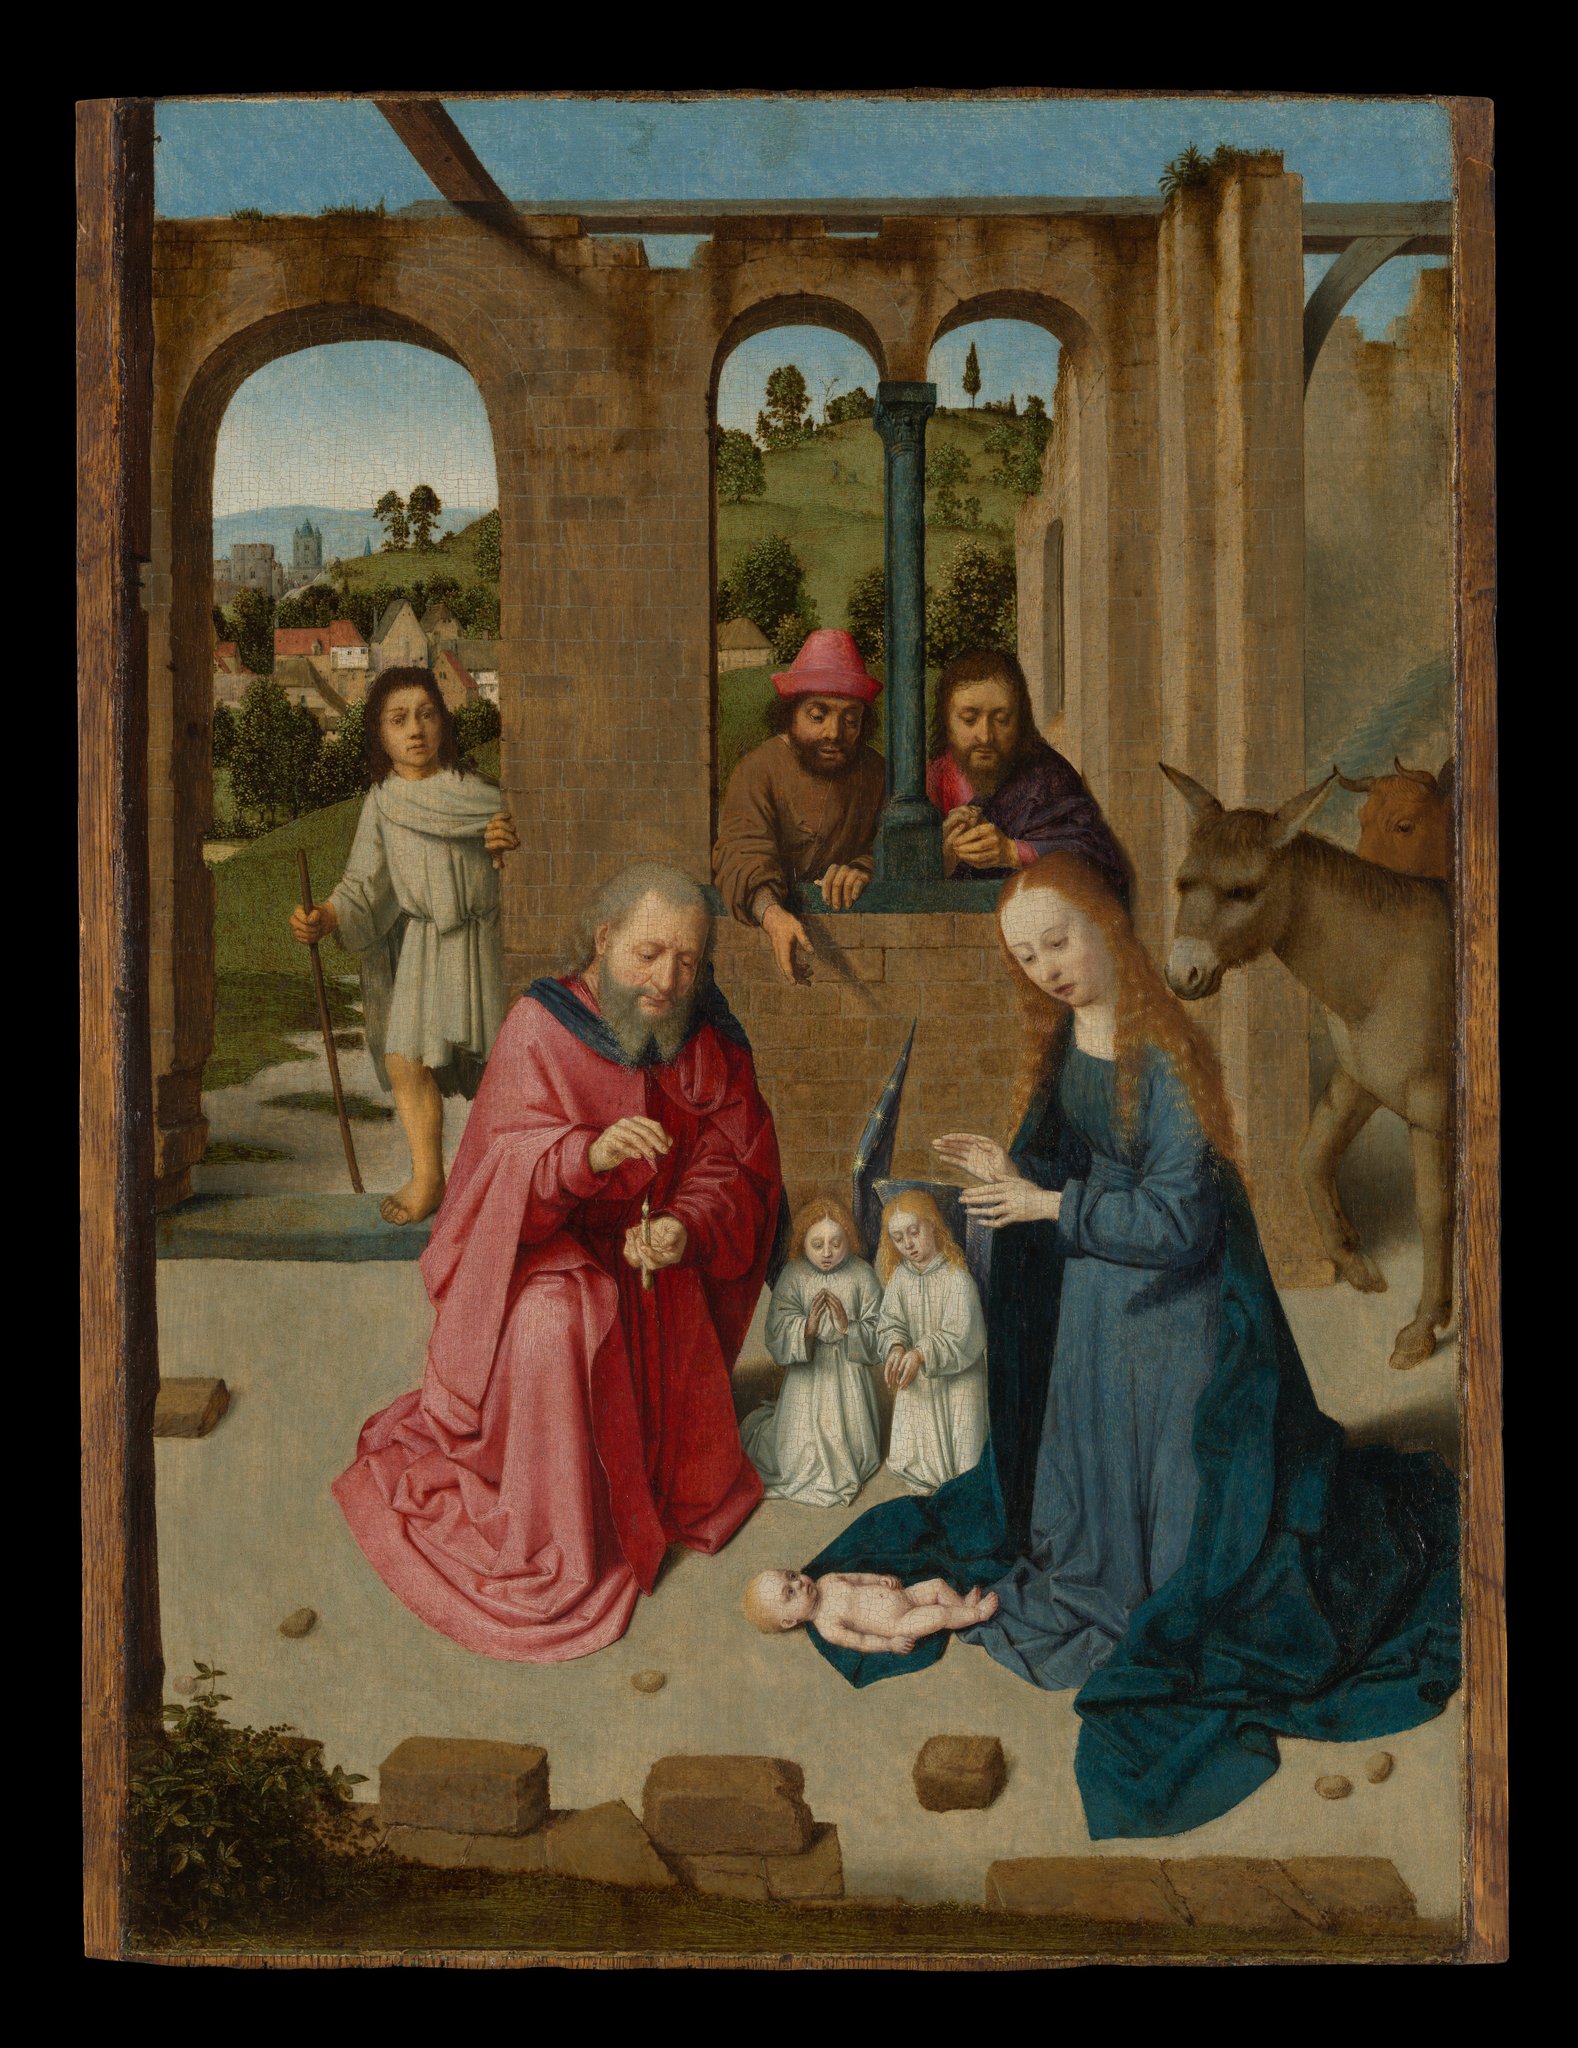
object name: painting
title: The Nativity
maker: gerard david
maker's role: artist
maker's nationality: netherlandish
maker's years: 1455-1523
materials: oil, wood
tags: animals,men,angels,christ,virgin mary,nativity